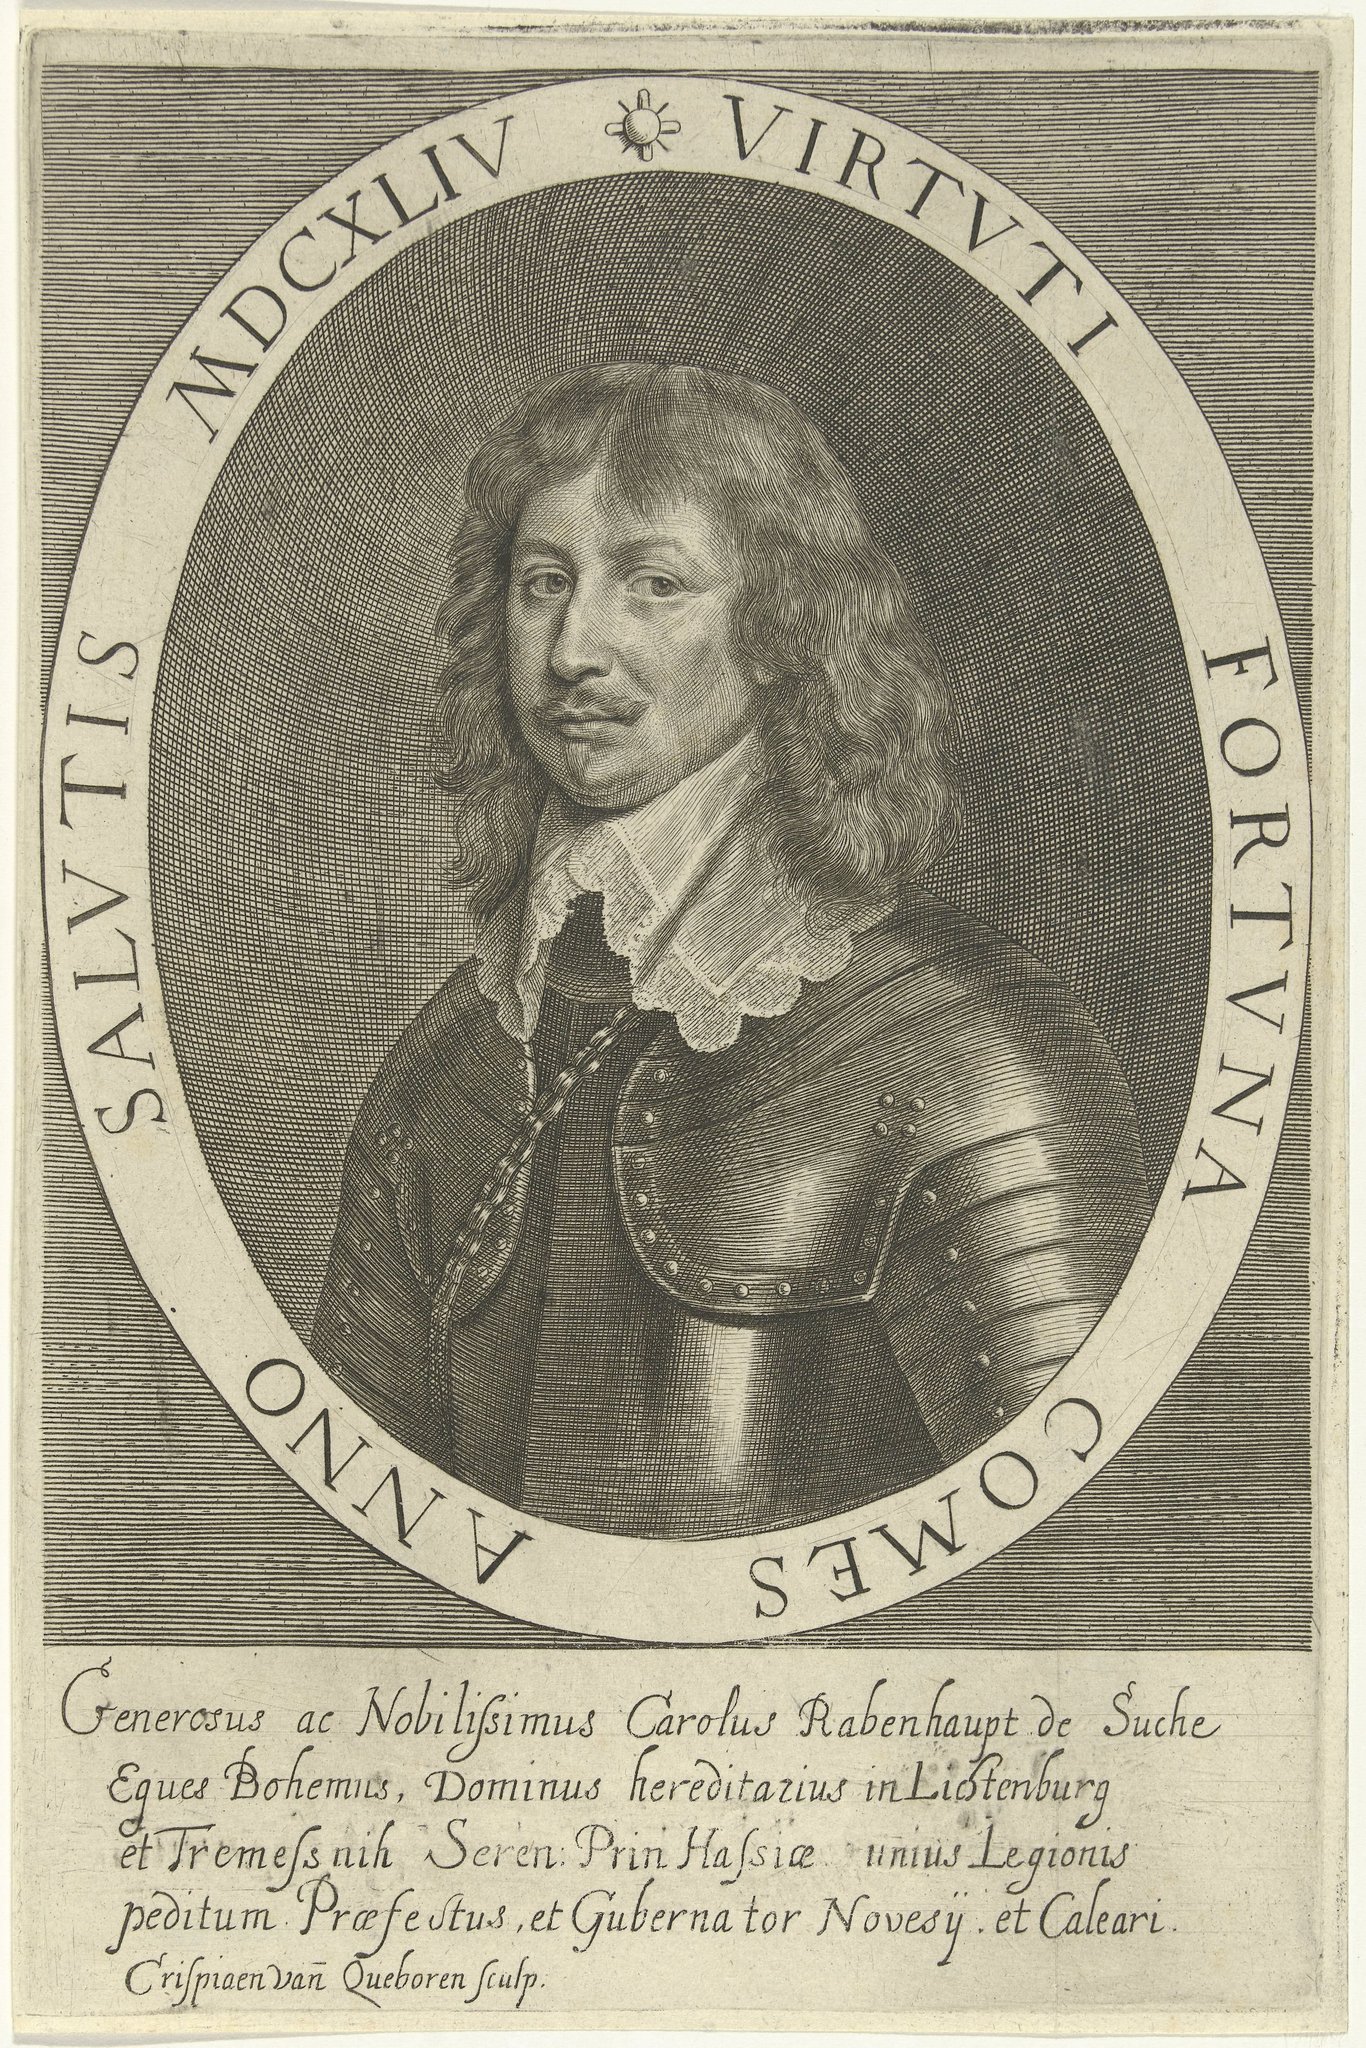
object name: print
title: Portret van Karl von Rabenhaupt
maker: crispijn van den queborn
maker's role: print maker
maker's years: 1595-1652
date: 1644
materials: paper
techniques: engraving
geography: the hague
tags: bohemen, coevorden, gouverneur, karl rabenhaupt (baron von sucha)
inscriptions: collector's mark: Lugt 2228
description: Portret van luitenant-generaal Karl Rabenhaupt, baron de Sucha, erfheer van Lichtenberg en Fremesnich, heer tot Grumbach. Rabenhaupt speelde een hoofdrol bij de verdediging van Groningen en de inname van Coevorden (1672). In de marge zijn naam en titels.